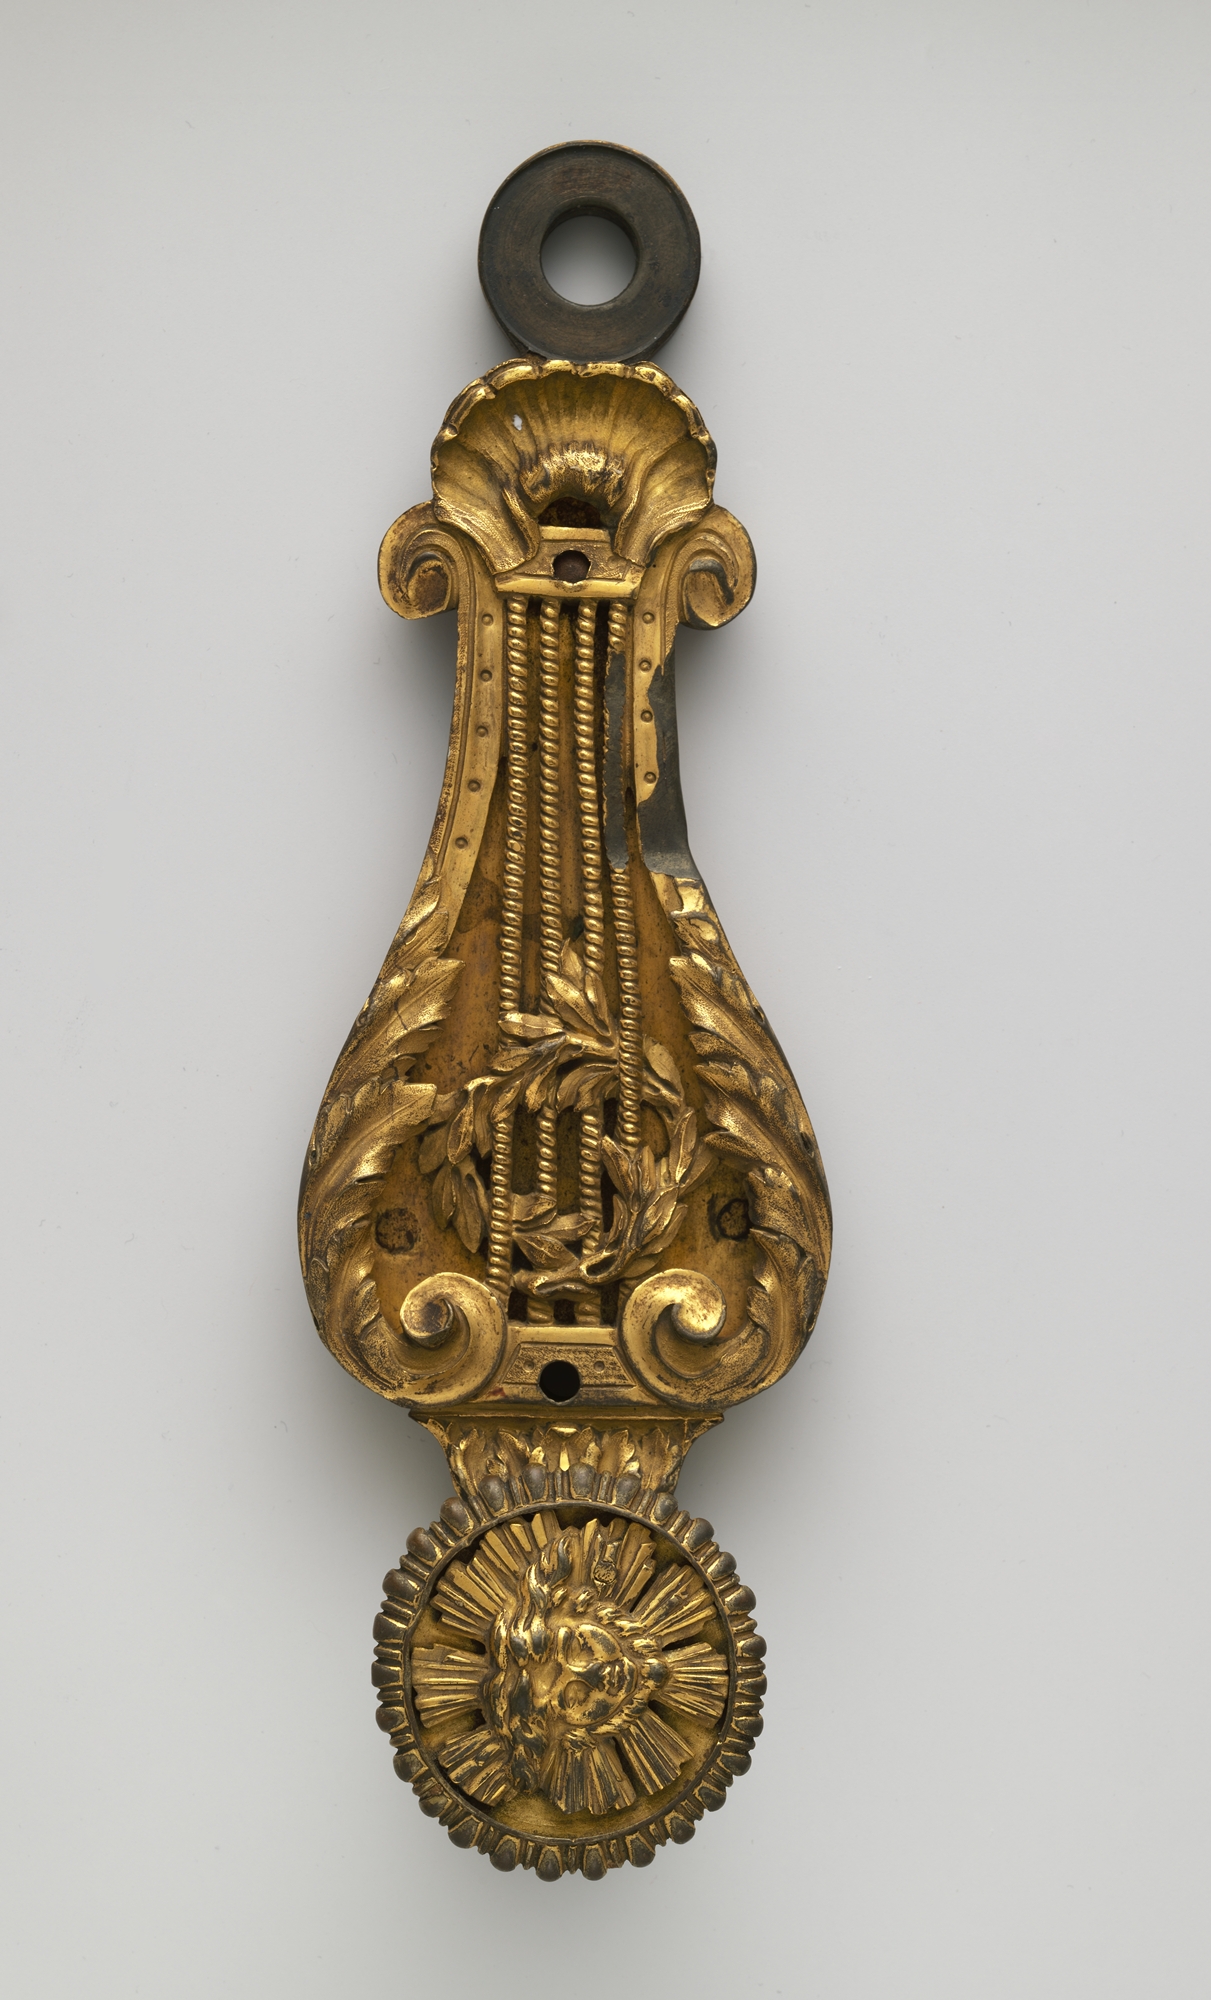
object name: espagnolettes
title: Set of three espagnolettes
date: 1701-1800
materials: gilt bronze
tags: lyres